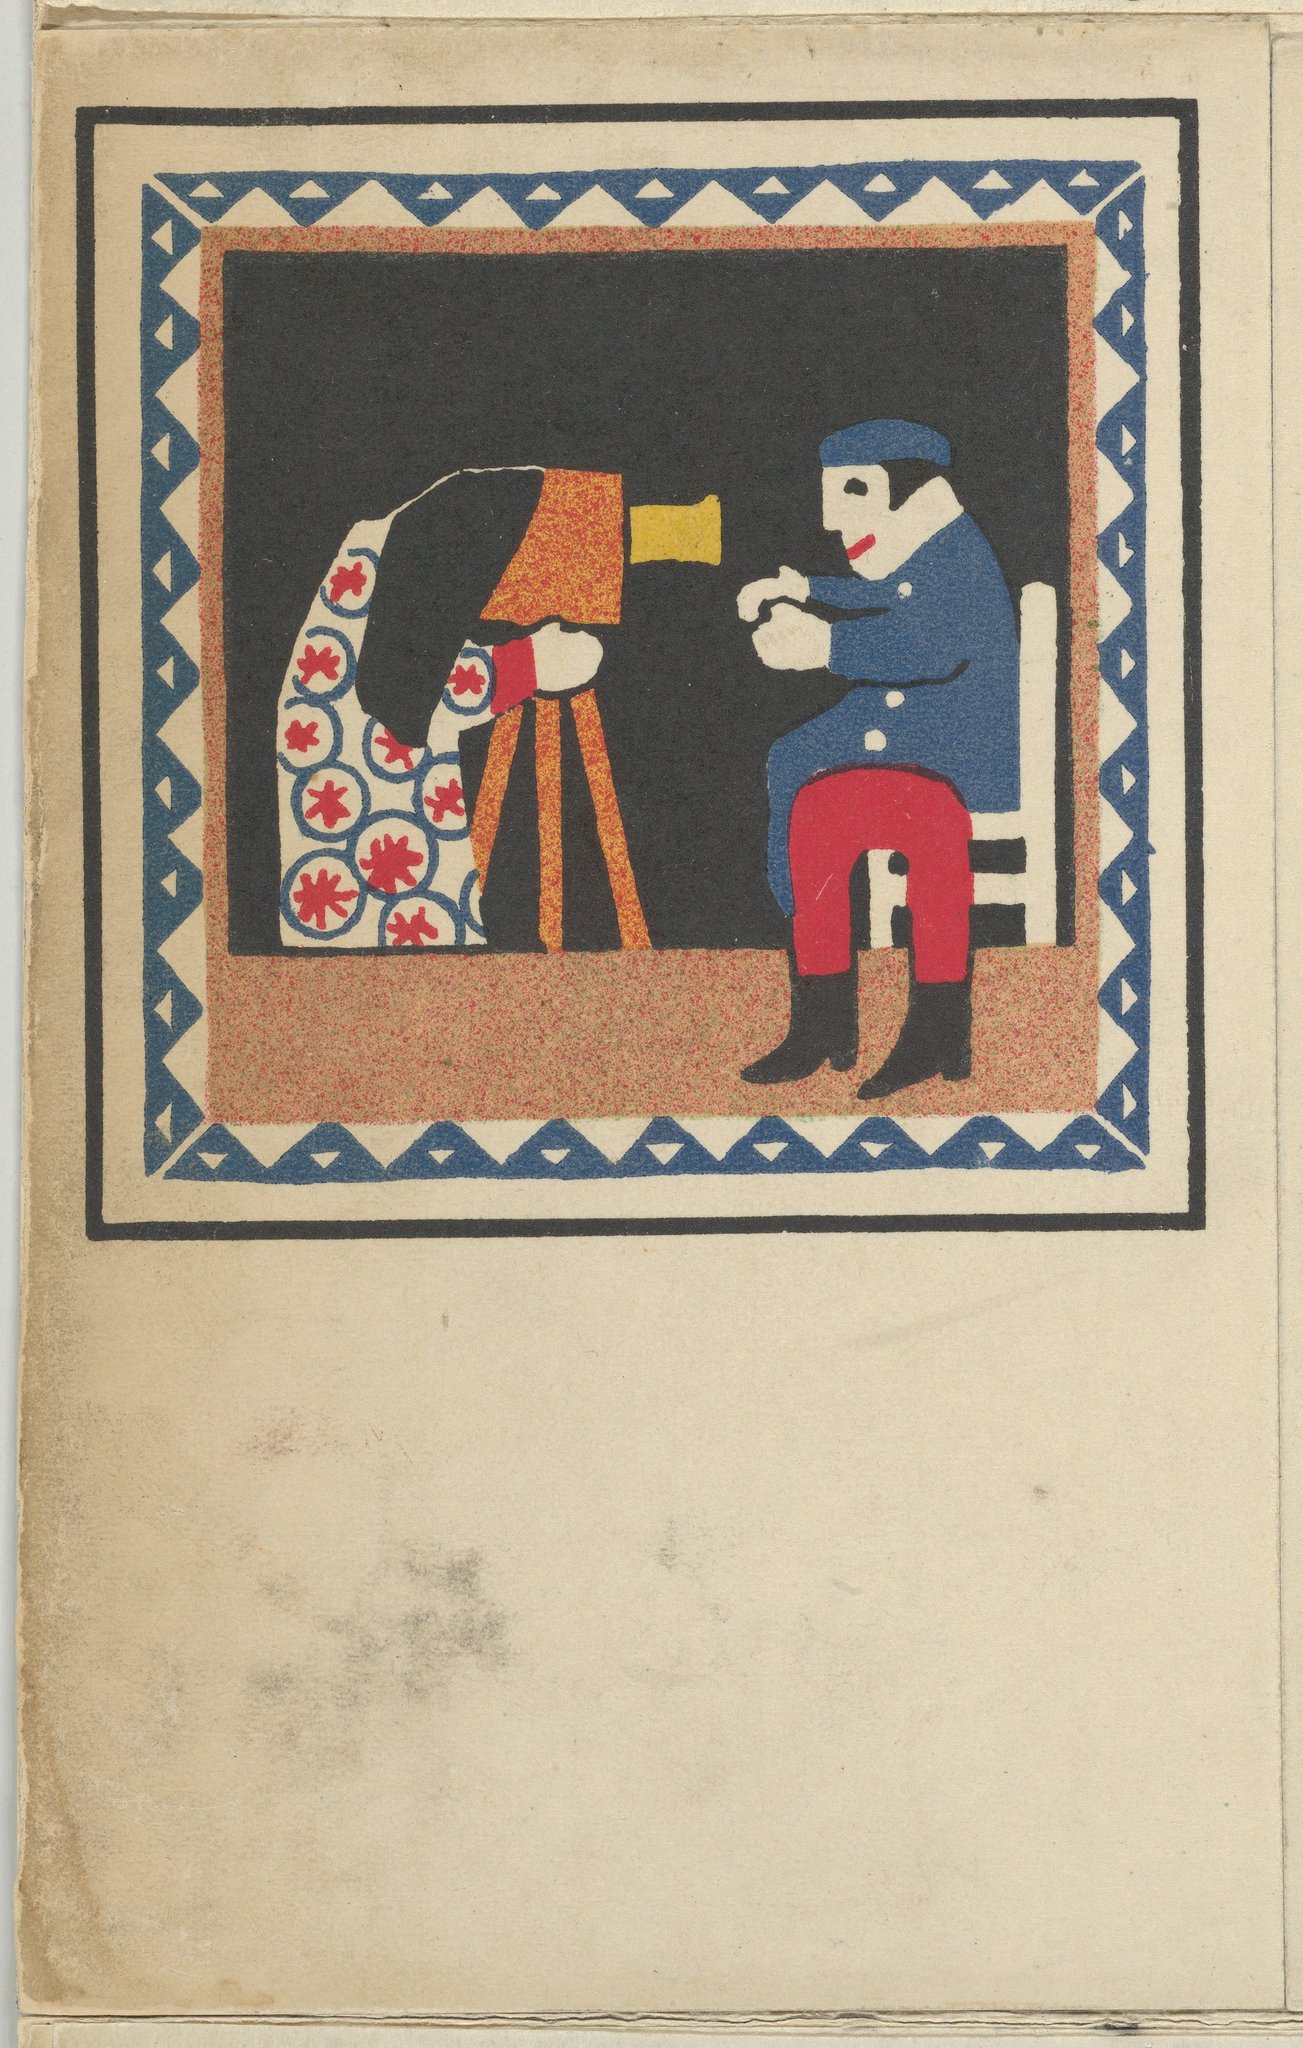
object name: print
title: Kasperltheater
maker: hans kalmsteiner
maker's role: artist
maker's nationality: austrian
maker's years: 1882-1914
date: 1907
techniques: lithograph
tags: photography,men